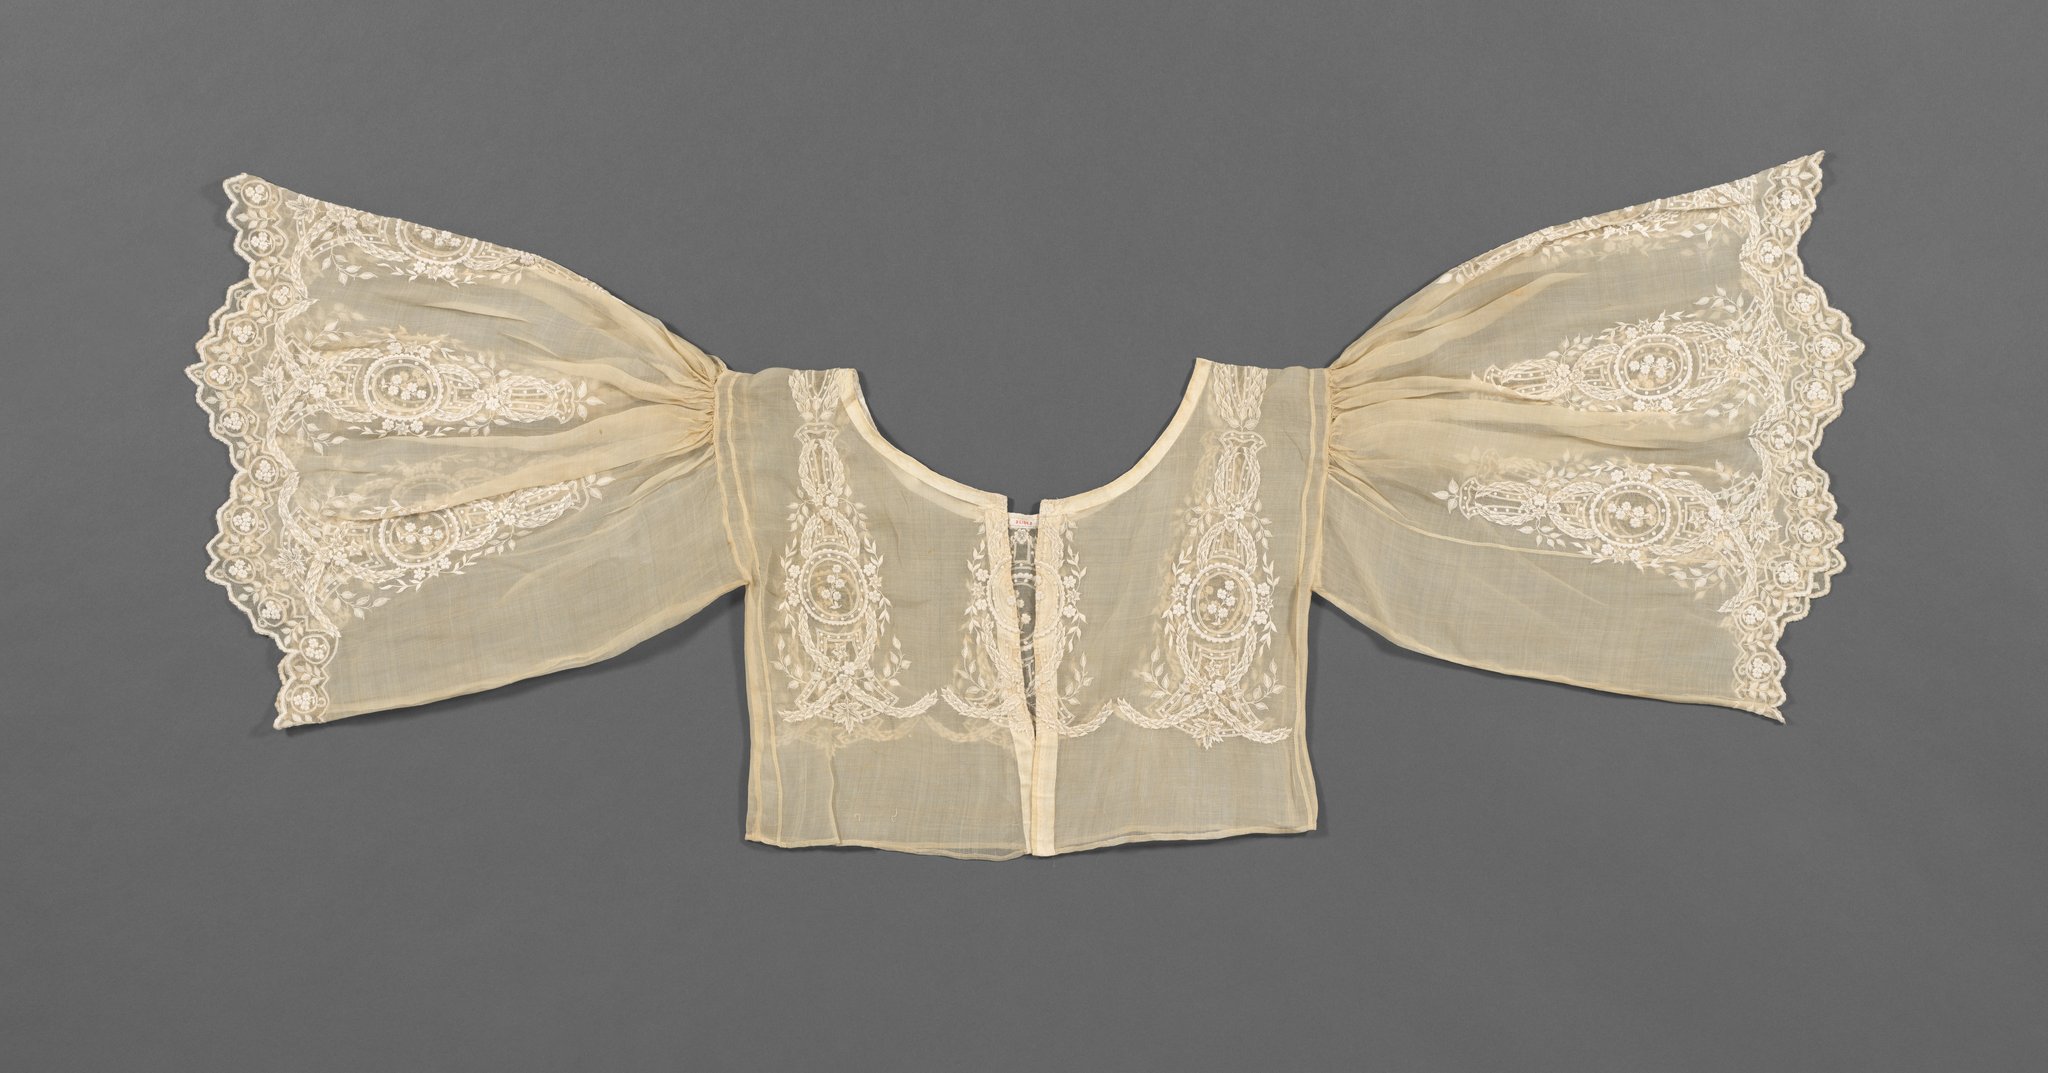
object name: blouse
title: Blouse (Camisa)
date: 1801-1850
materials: fiber